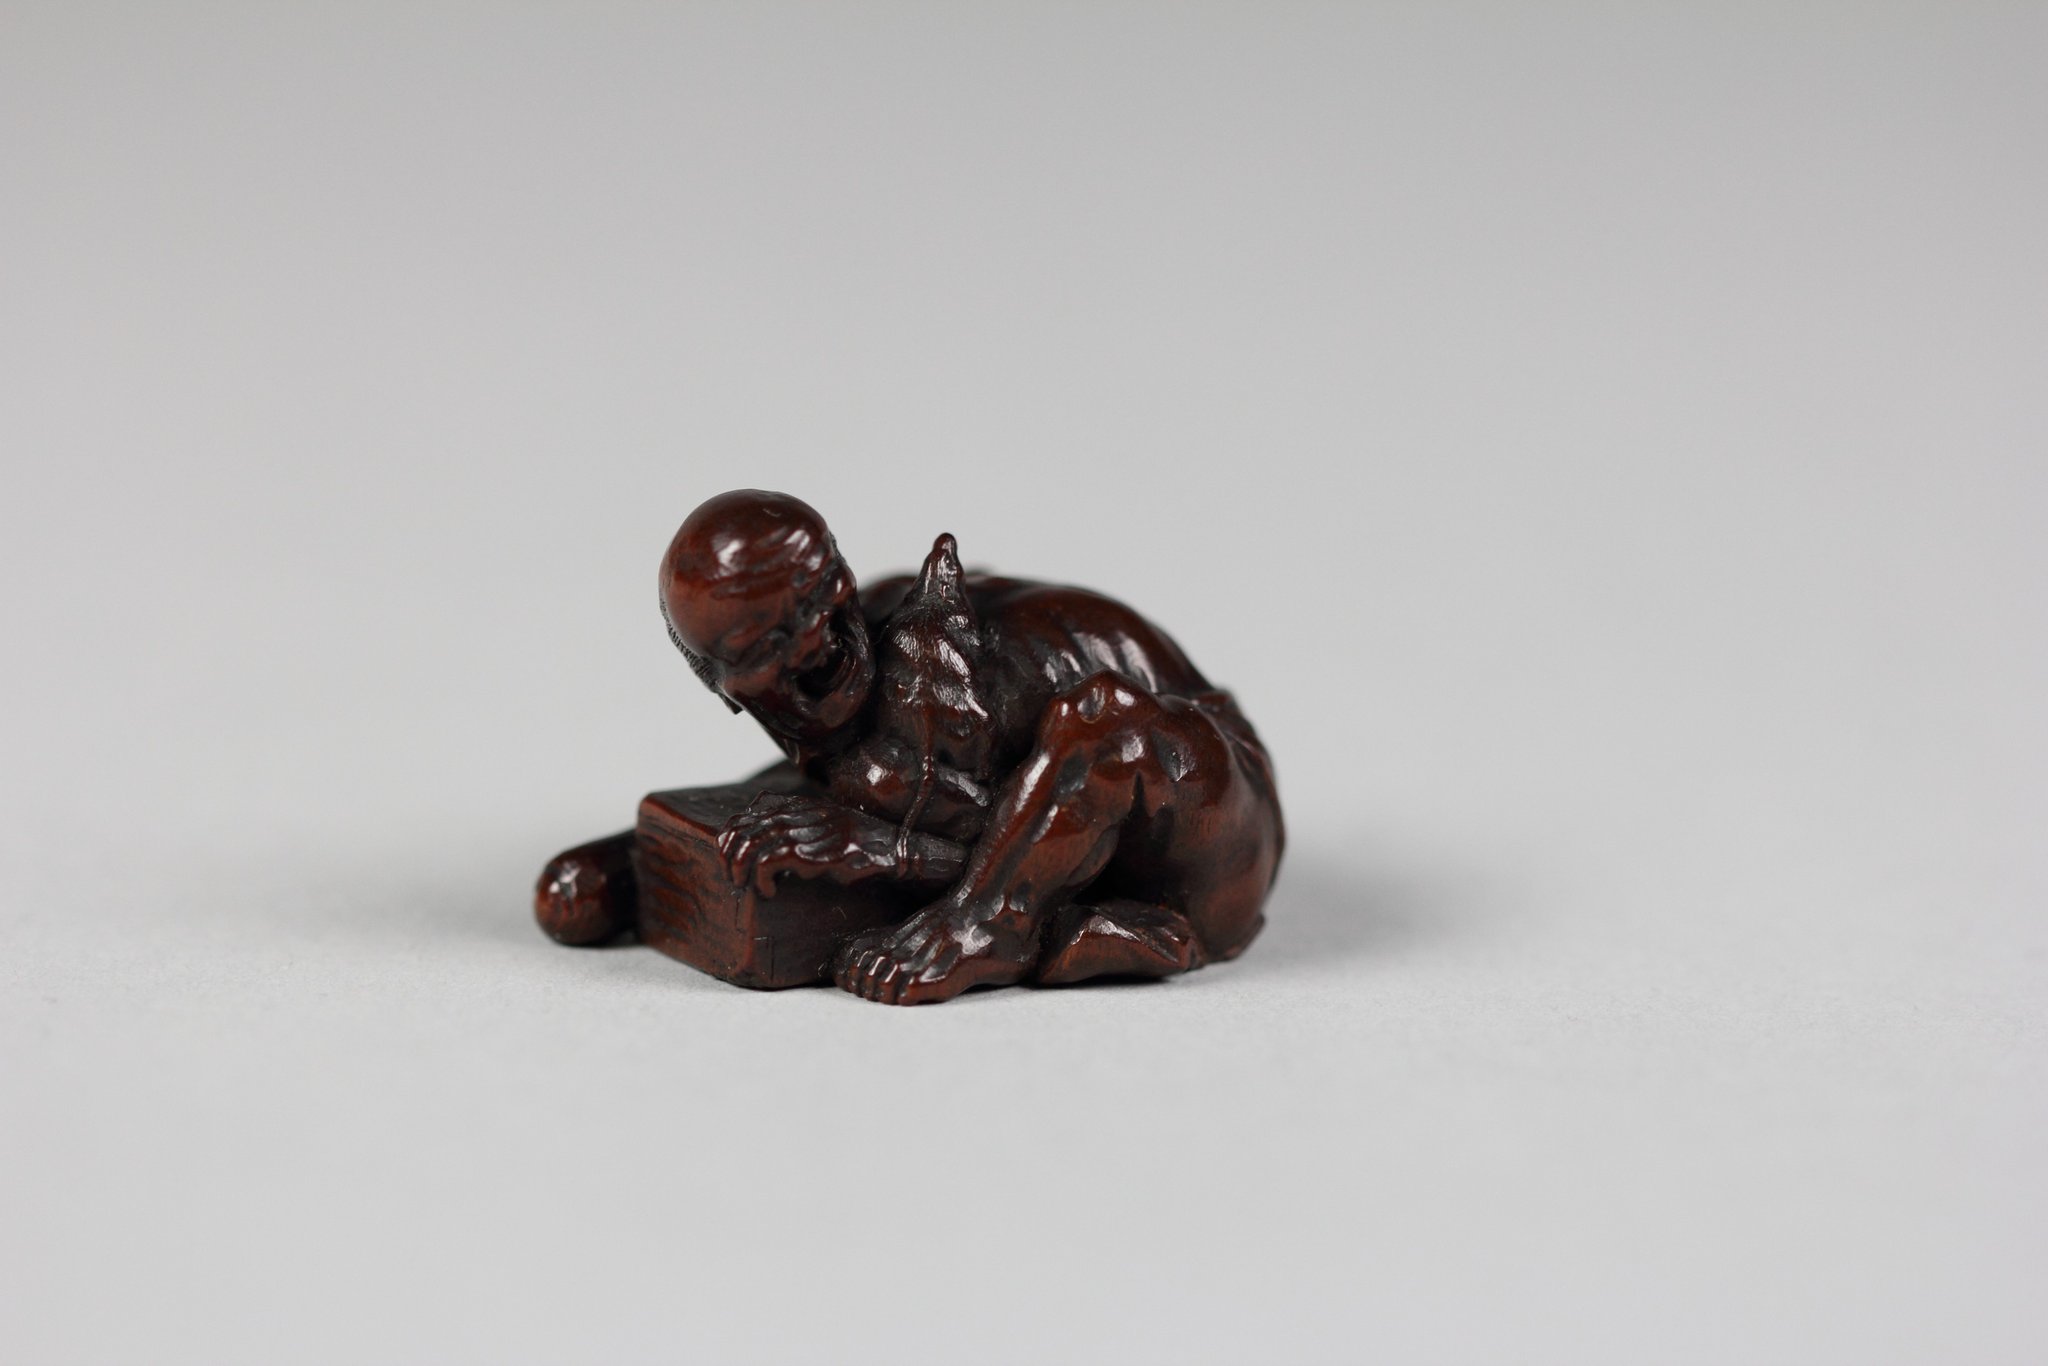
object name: netsuke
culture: japanese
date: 1801-1900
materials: wood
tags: men